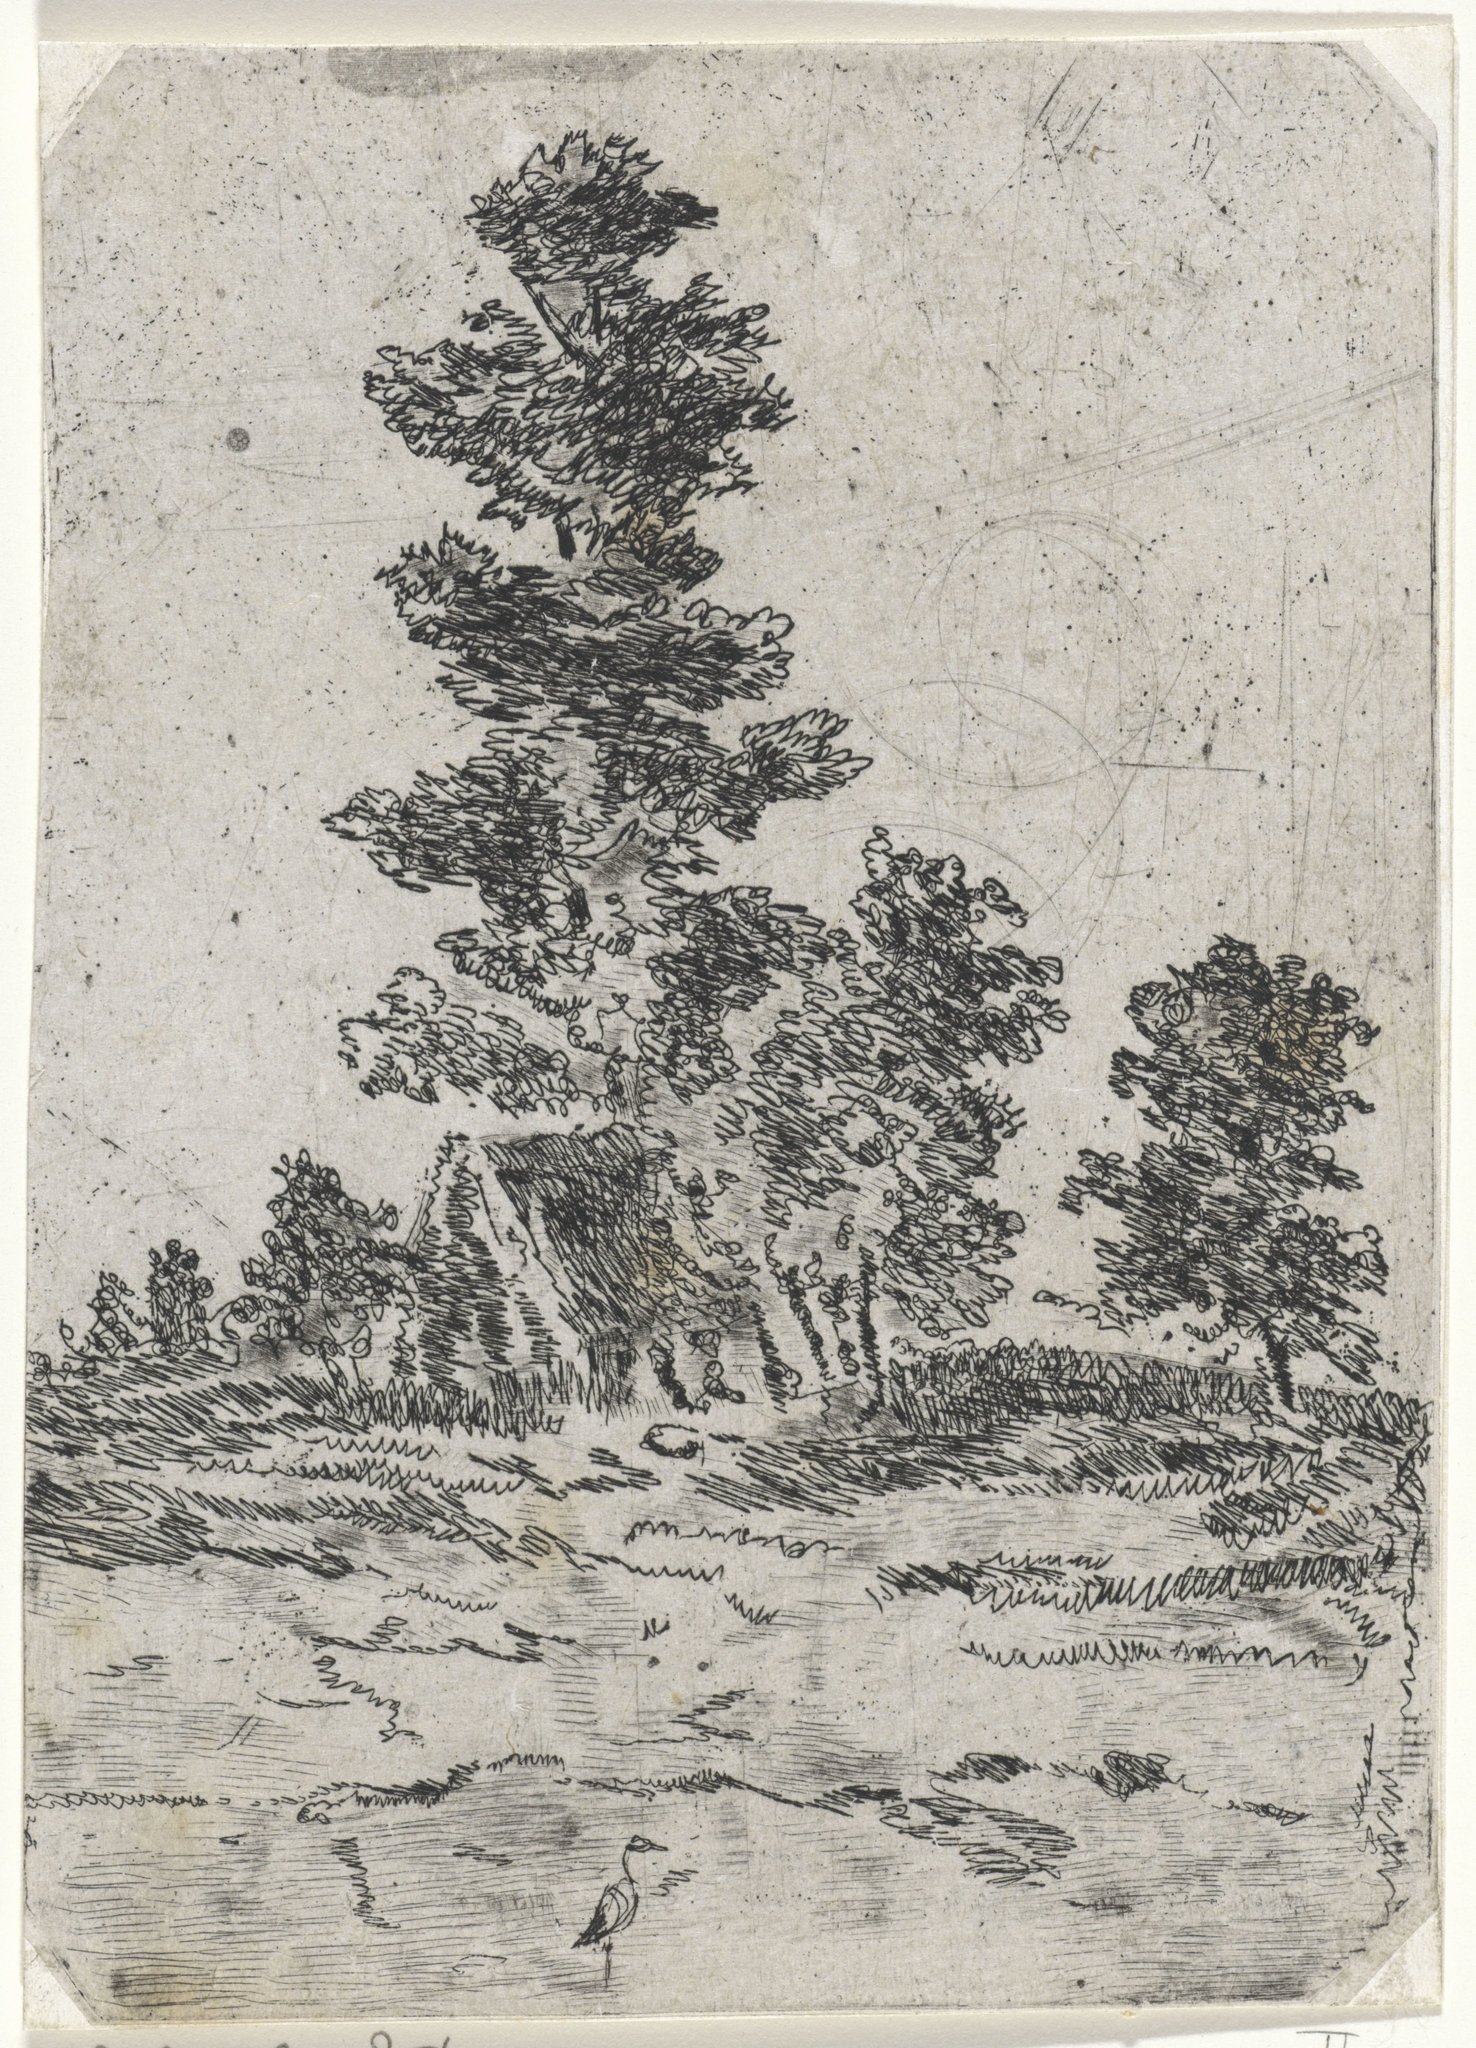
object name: print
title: Landschap met een hut onder bomen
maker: arnoud schaepkens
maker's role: print maker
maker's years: 1816-1904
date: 1831-1904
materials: paper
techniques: drypoint, etching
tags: trees, landscapes in the temperate zone, cottage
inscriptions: collector's mark: Lugt 2228